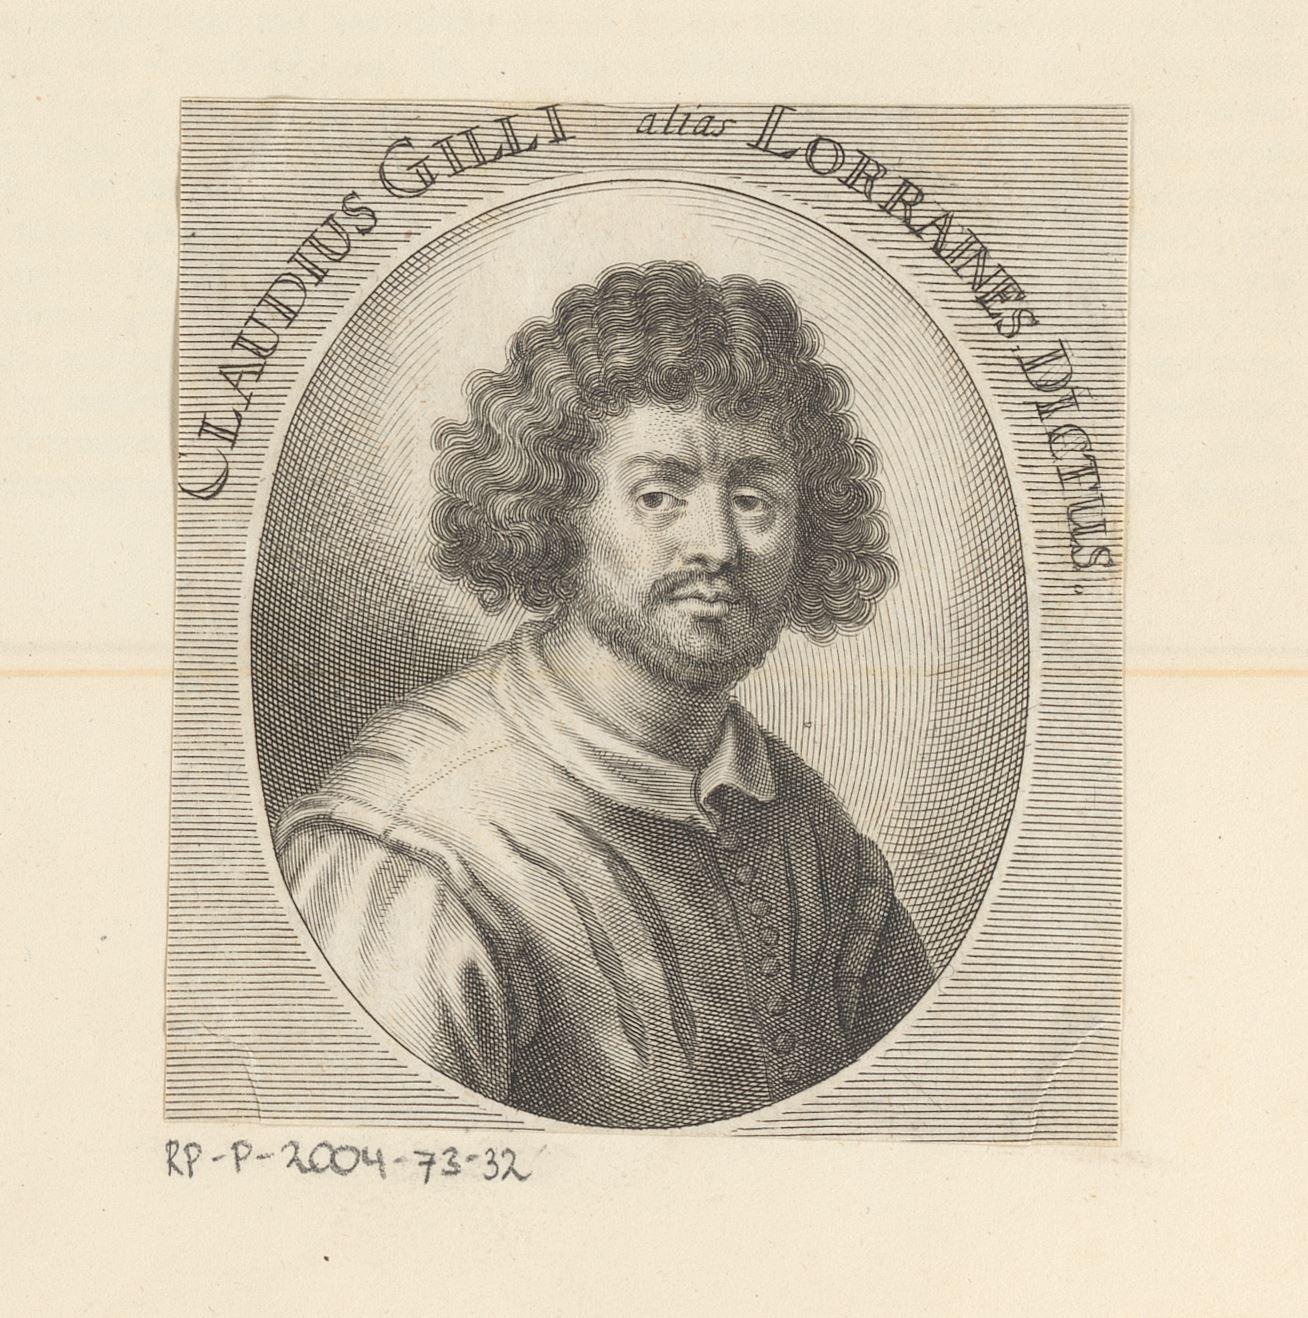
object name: print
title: Claudius Gilli alias Lorraine Dictus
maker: richard collin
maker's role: print maker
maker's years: 1627-1697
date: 1768-1775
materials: paper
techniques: engraving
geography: nuremberg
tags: rome, draughtsman, claude lorrain, historical persons, portrait, self-portrait of painter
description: Prent uit: Sandrart, Joachim von. Teutsche Academie der Bau- Bildhauer- und Maler-Kunst: worinn die Regeln und Lehrsätze dieser Künste gegeben. 14 dln. Neurenberg: erven Johann Andreas Endter, [1774], dl. 7, p. ii. De samensteller heeft deze prent in het album geplakt als illustratie bij: Pilkington, Matthew en Johann Heinrich Füssli. A dictionary of painters, from the revival of the art to the present period. 4 dln. Londen: John Crowder, 1805, dl. 2, p. 212.